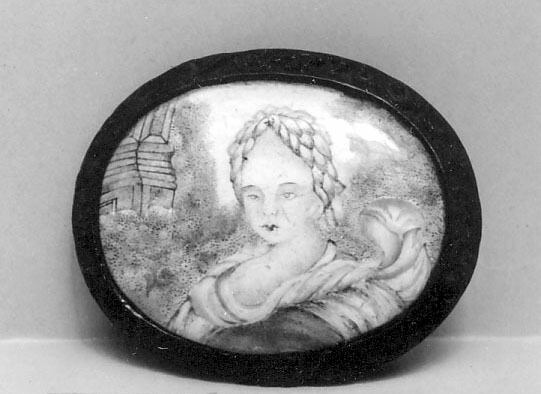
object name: buckle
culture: chinese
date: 1736-1795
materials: enamel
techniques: painting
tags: women